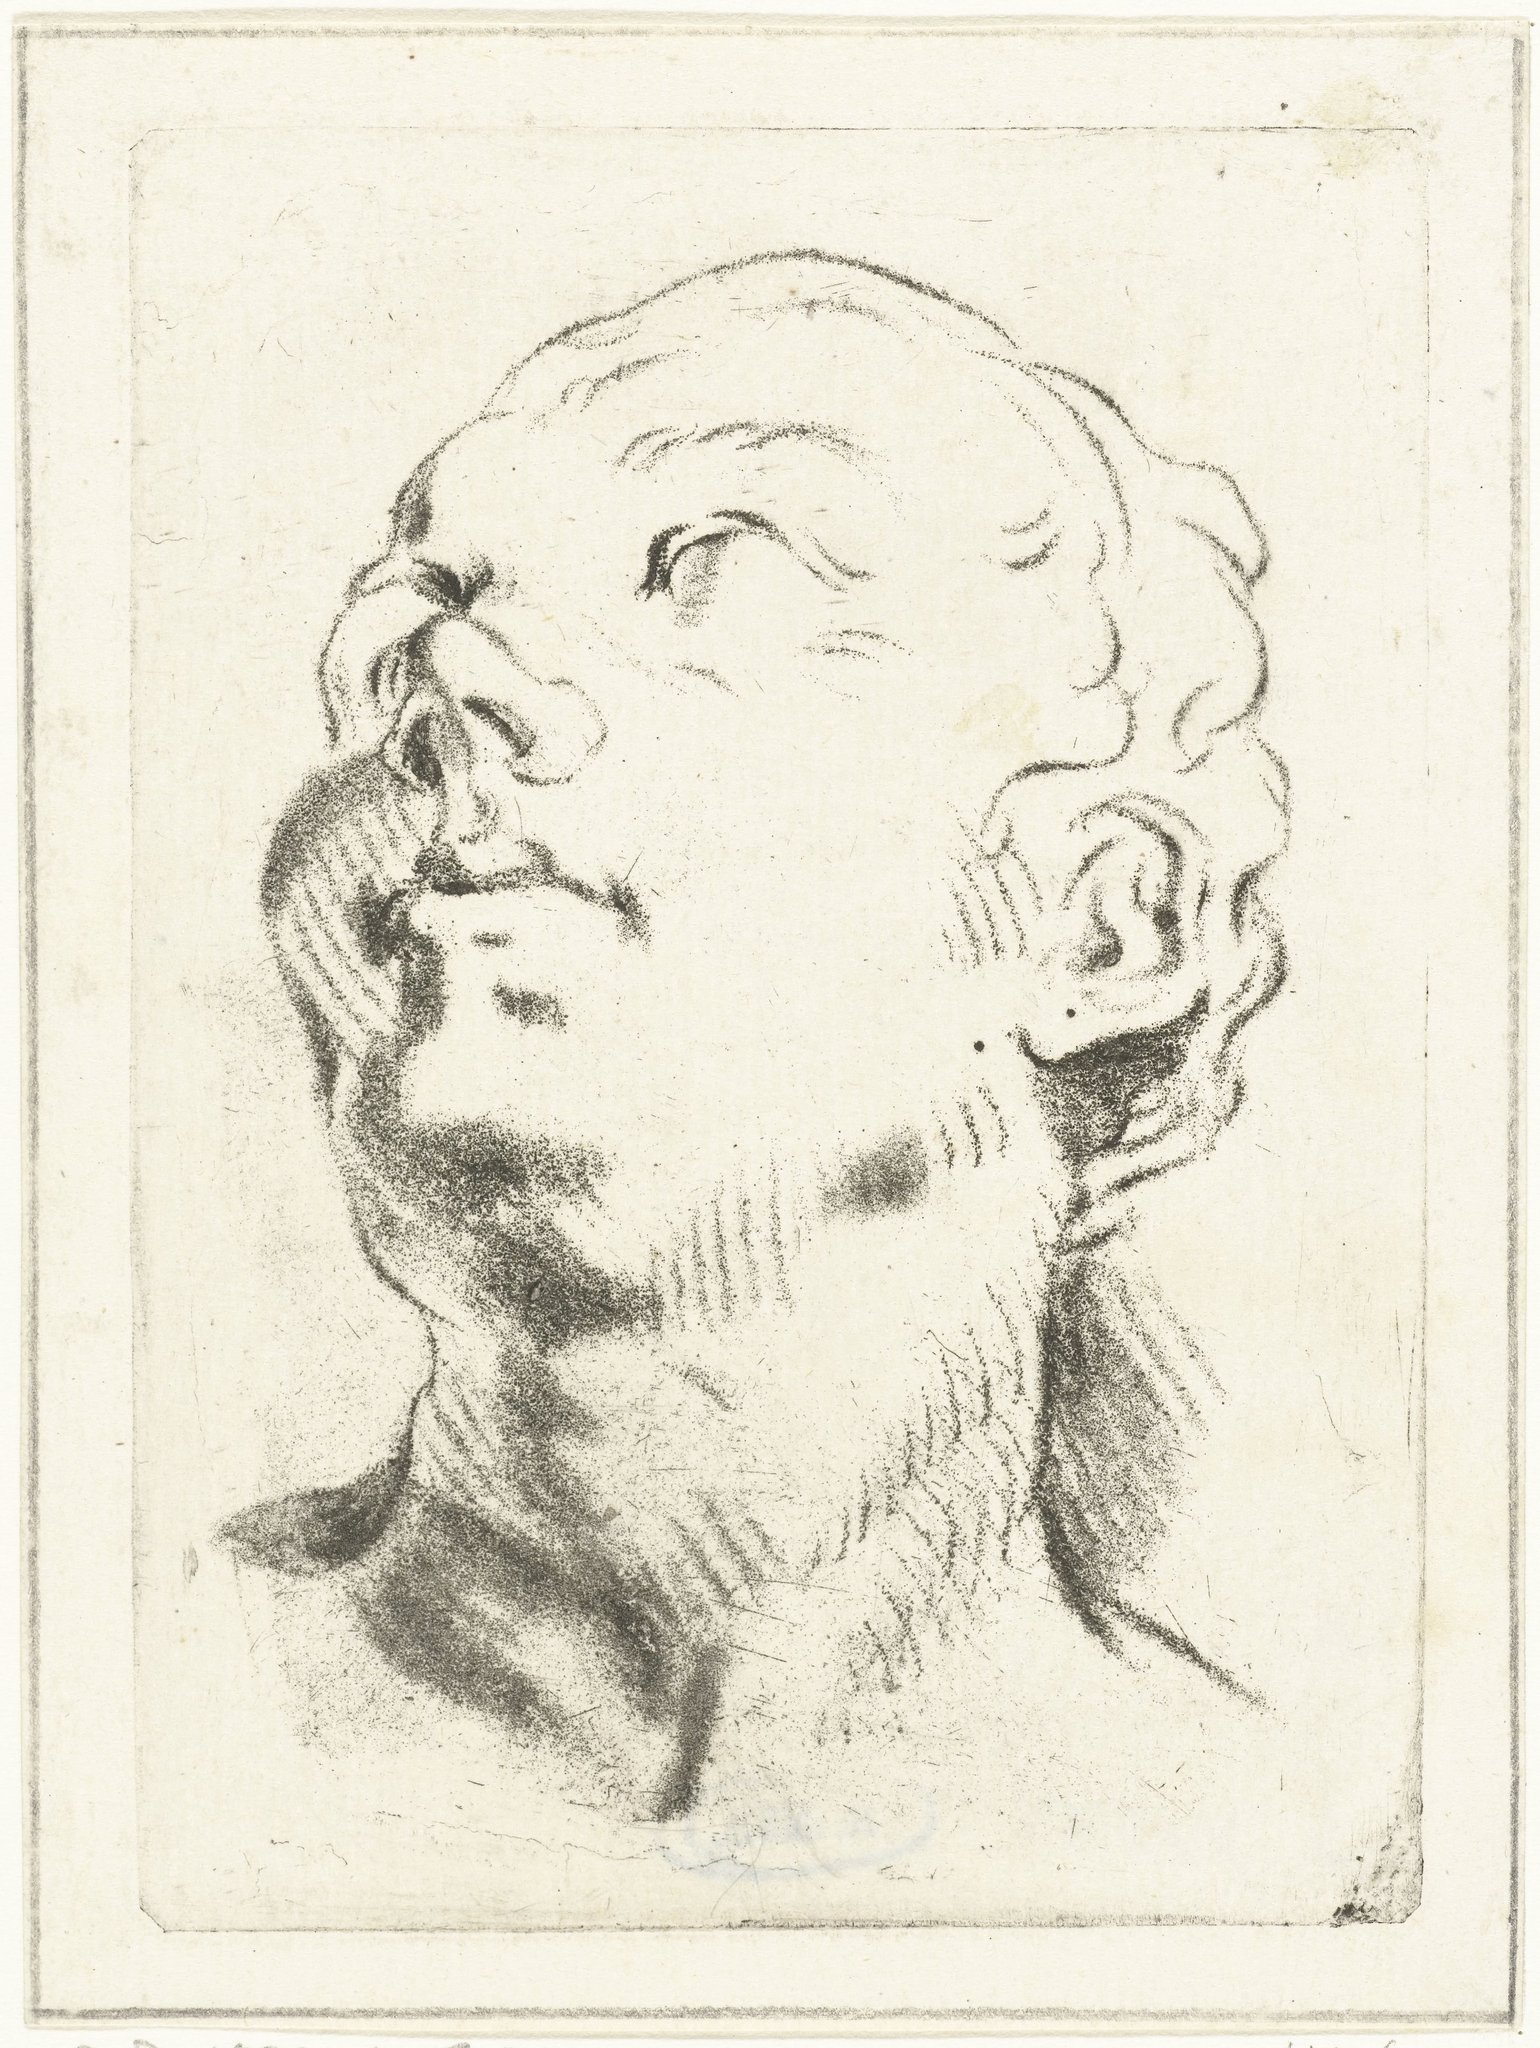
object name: print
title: Studieblad met een hoofd, de blik naar boven gericht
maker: louis bernard coclers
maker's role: draughtsman, print maker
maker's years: 1741-1817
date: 1756-1817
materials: paper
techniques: etching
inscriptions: collector's mark: Lugt 2228